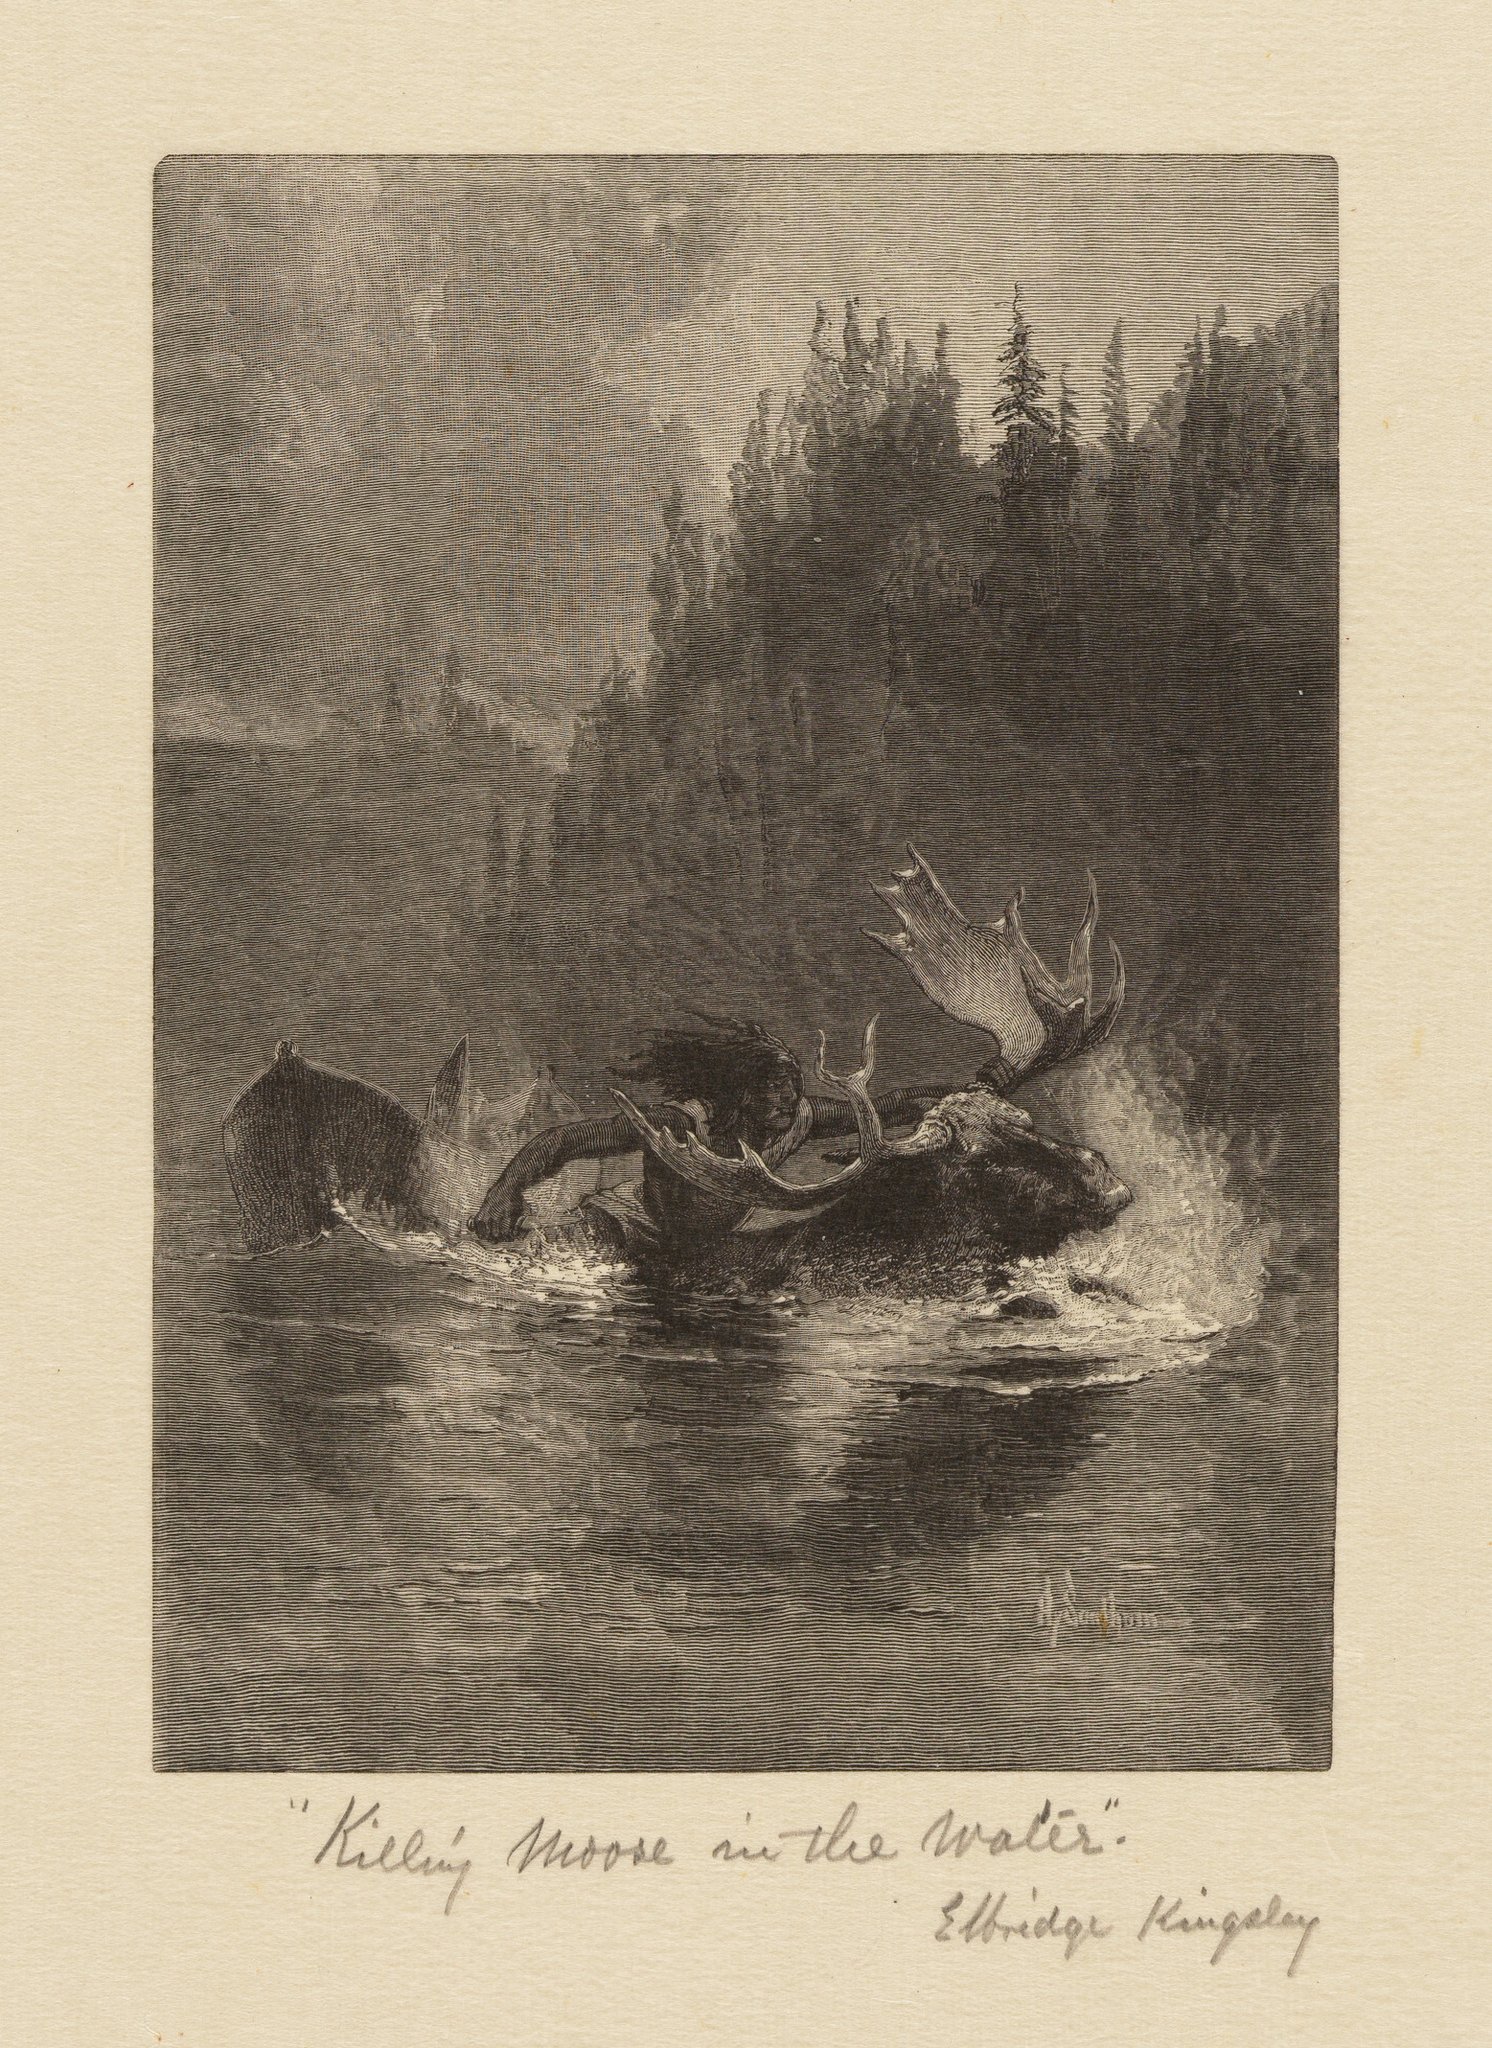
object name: print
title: Killing Moose in the Water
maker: elbridge kingsley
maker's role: artist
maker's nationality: american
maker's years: 1841-1918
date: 1885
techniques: engraving